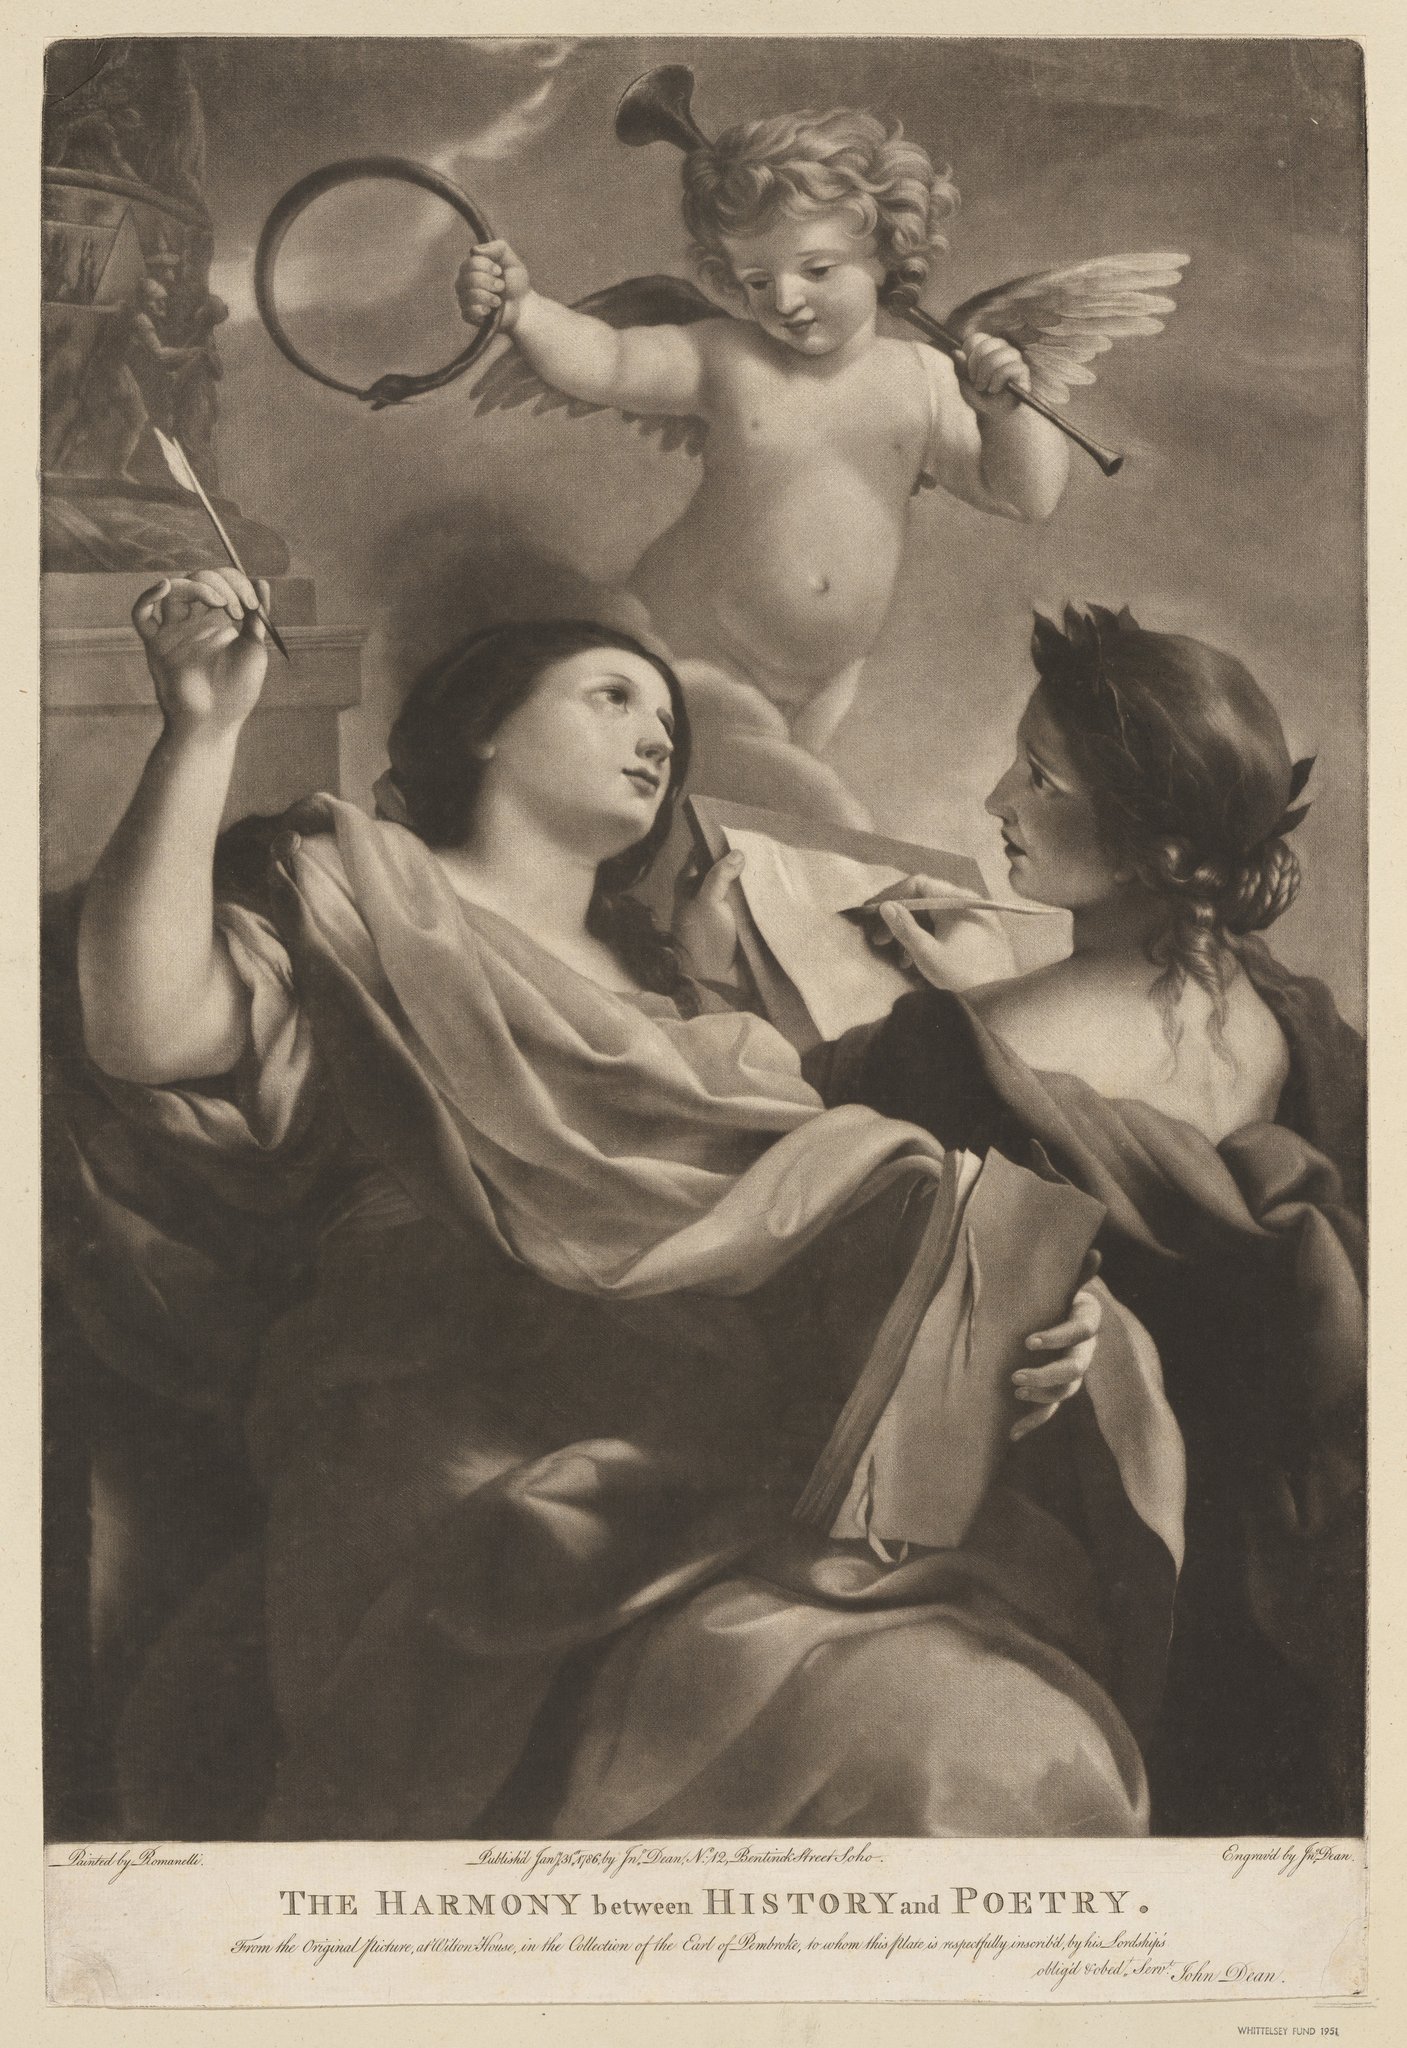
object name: print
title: The Harmony between History and Poetry, a putto with instruments overhead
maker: john dean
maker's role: artist and publisher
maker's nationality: british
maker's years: 1754-1798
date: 1786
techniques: mezzotint